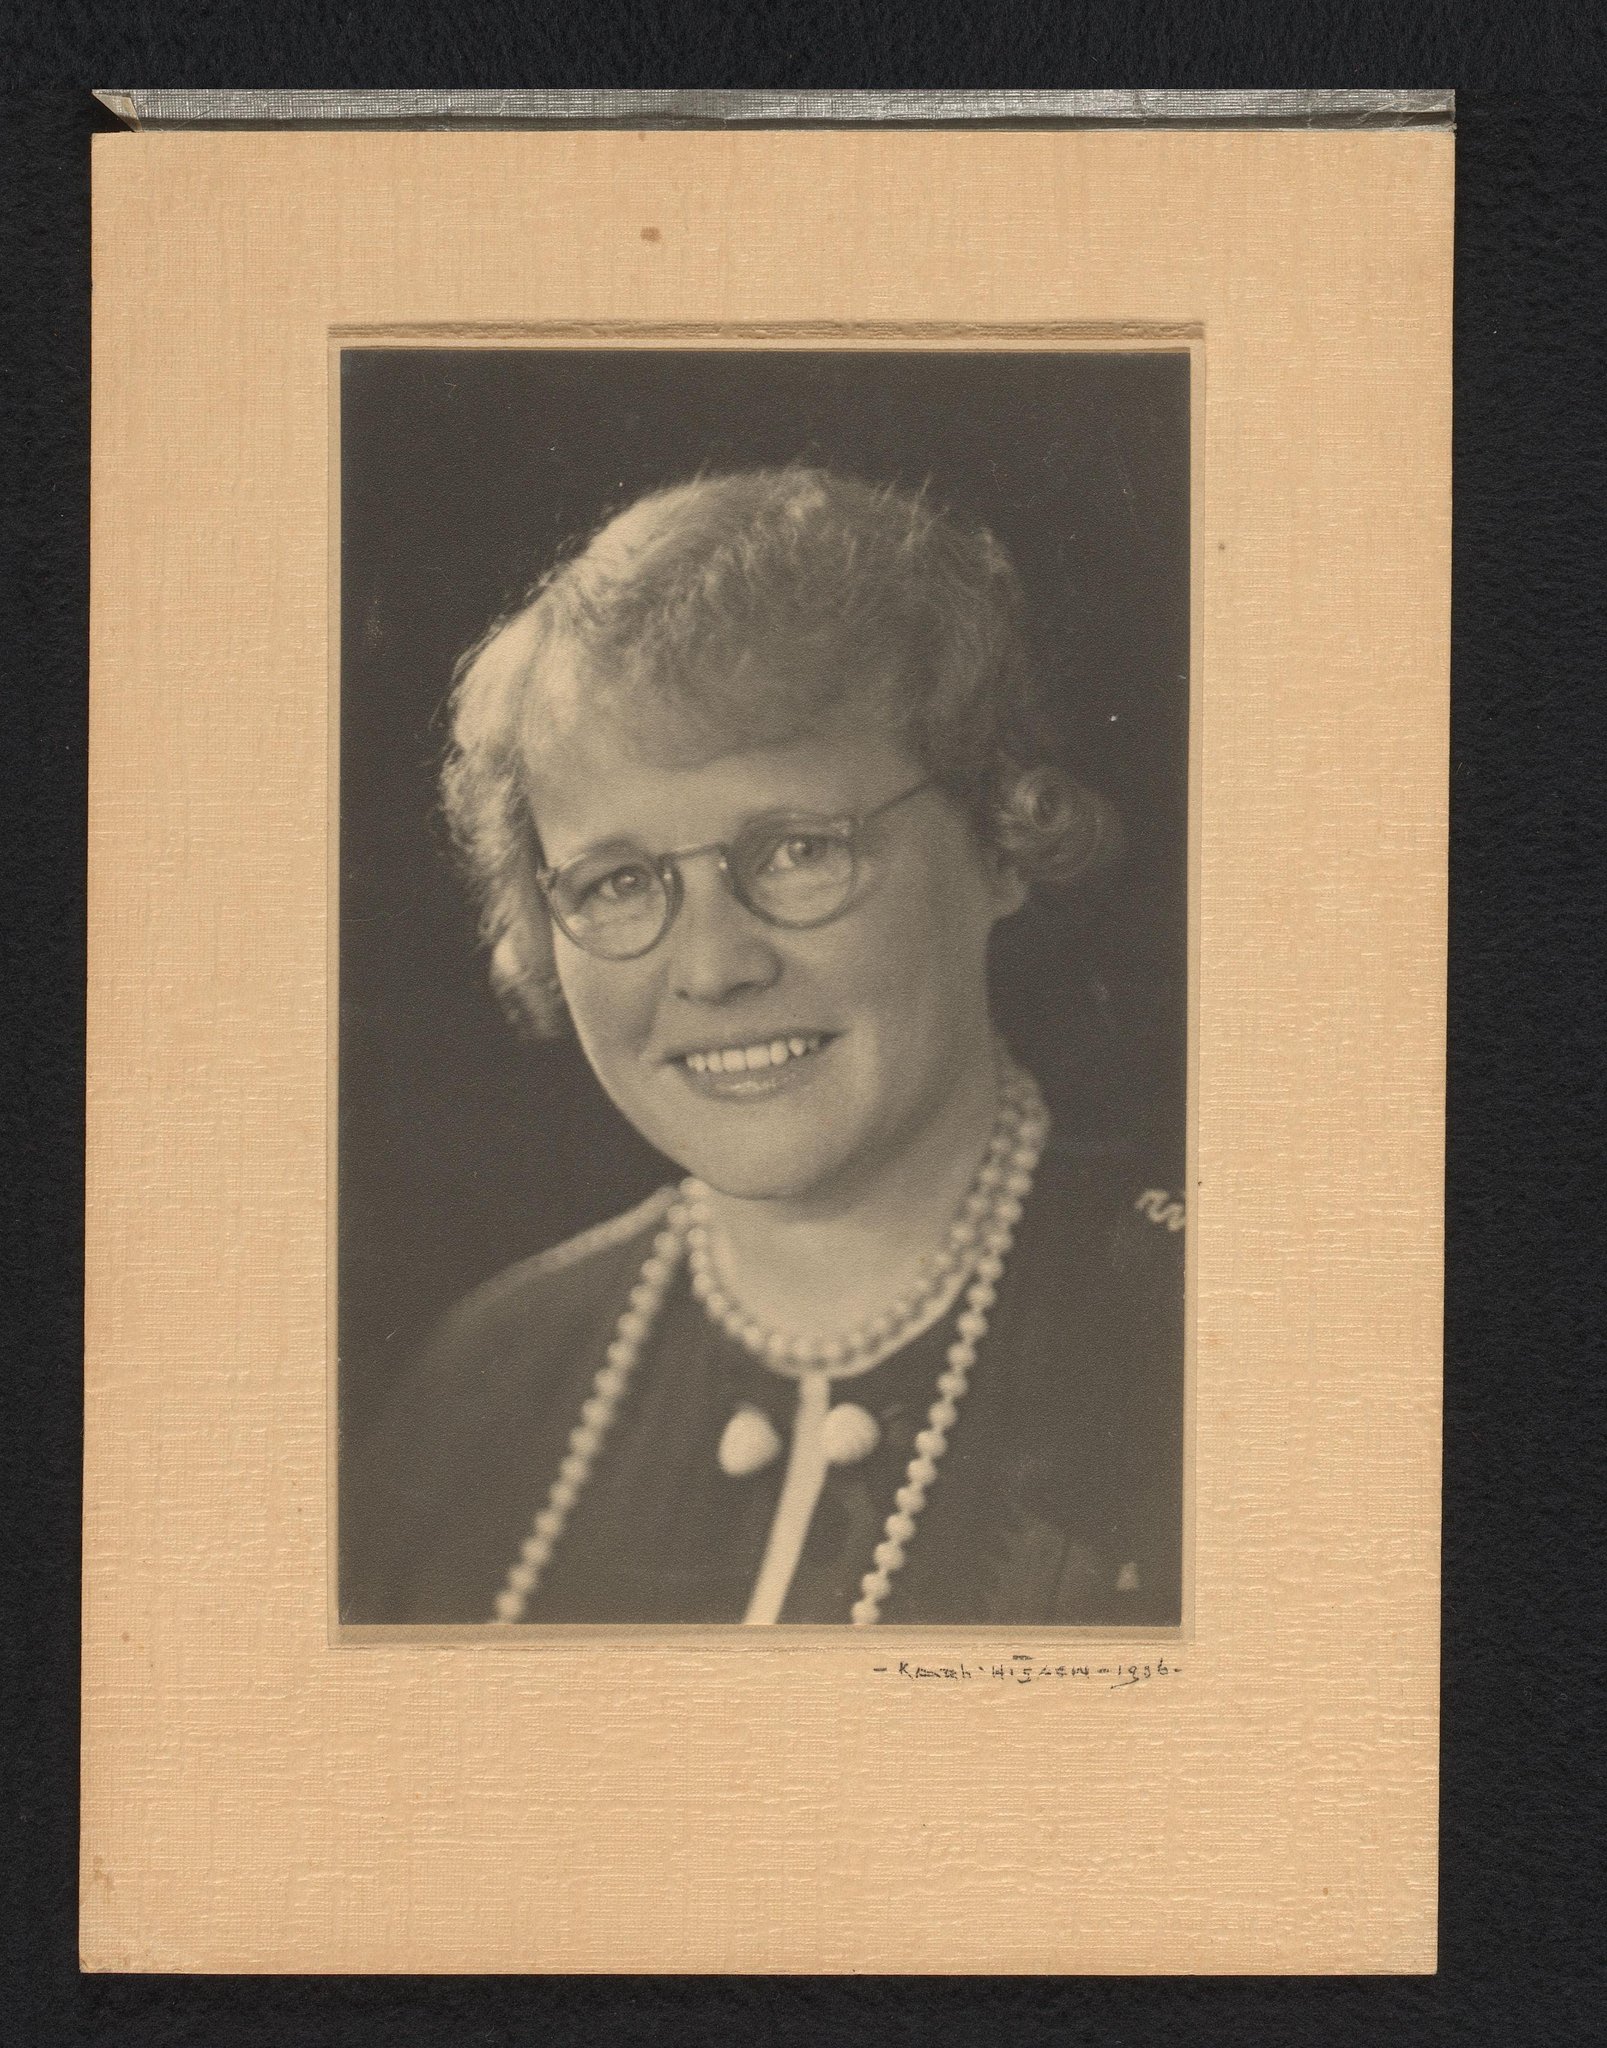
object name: photograph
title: Portret van een onbekende lachende vrouw met parelsnoer, mogelijk Jet de Vries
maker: Anonymous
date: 1936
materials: cardboard, photographic support, paper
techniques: gelatin silver print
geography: netherlands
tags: eyeglasses, spectacles, historical persons not known by name - bb - woman, smiling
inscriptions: inscription: ‘- Karh [...] - 1936 -’